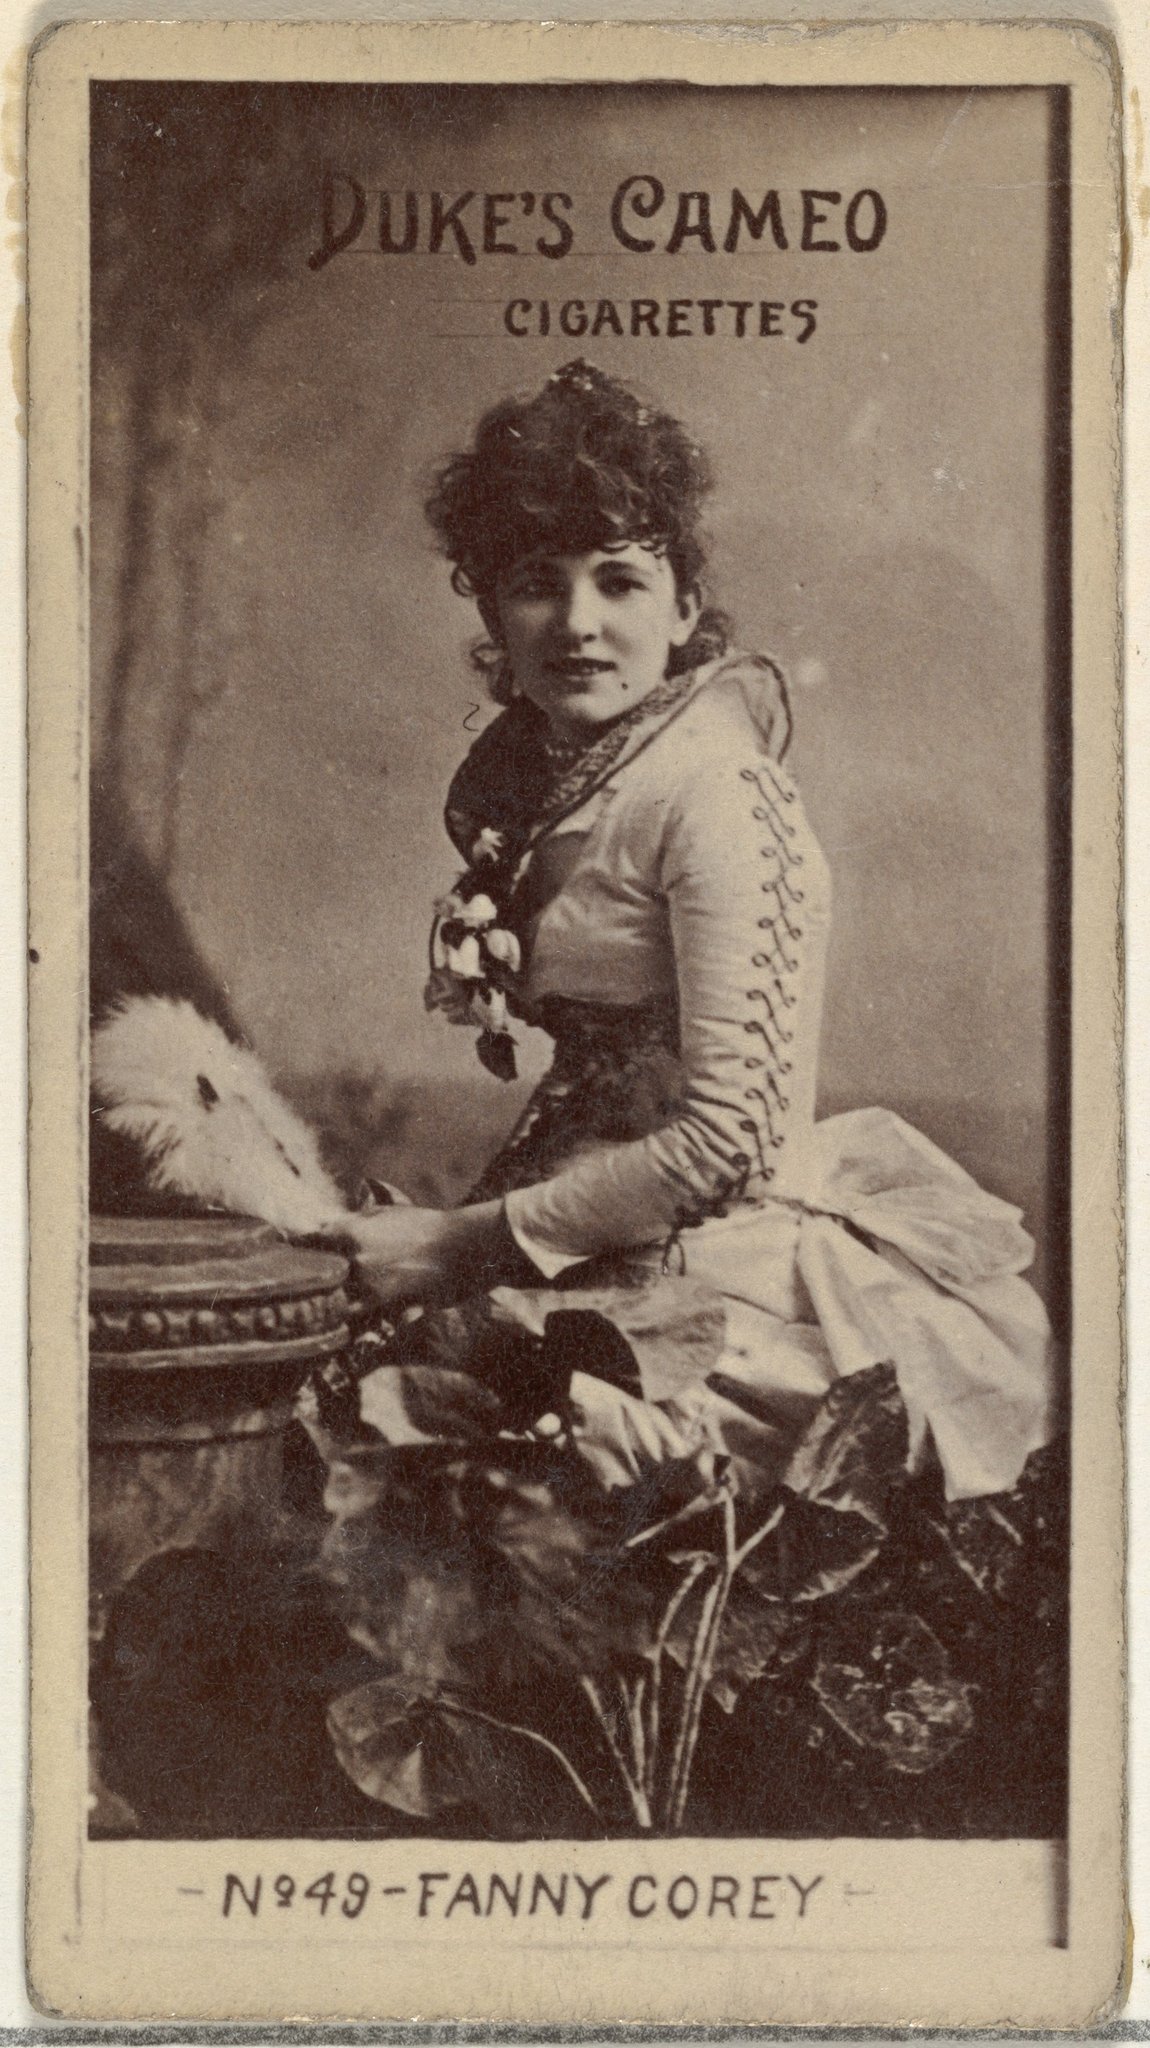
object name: photograph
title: Card Number 49, Fanny Corey, from the Actors and Actresses series (N145-4) issued by Duke Sons & Co. to promote Cameo Cigarettes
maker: w. duke, sons & co.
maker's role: publisher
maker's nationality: american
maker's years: 1870-1920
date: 1880-1889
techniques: albumen silver print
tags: portraits,women,actresses